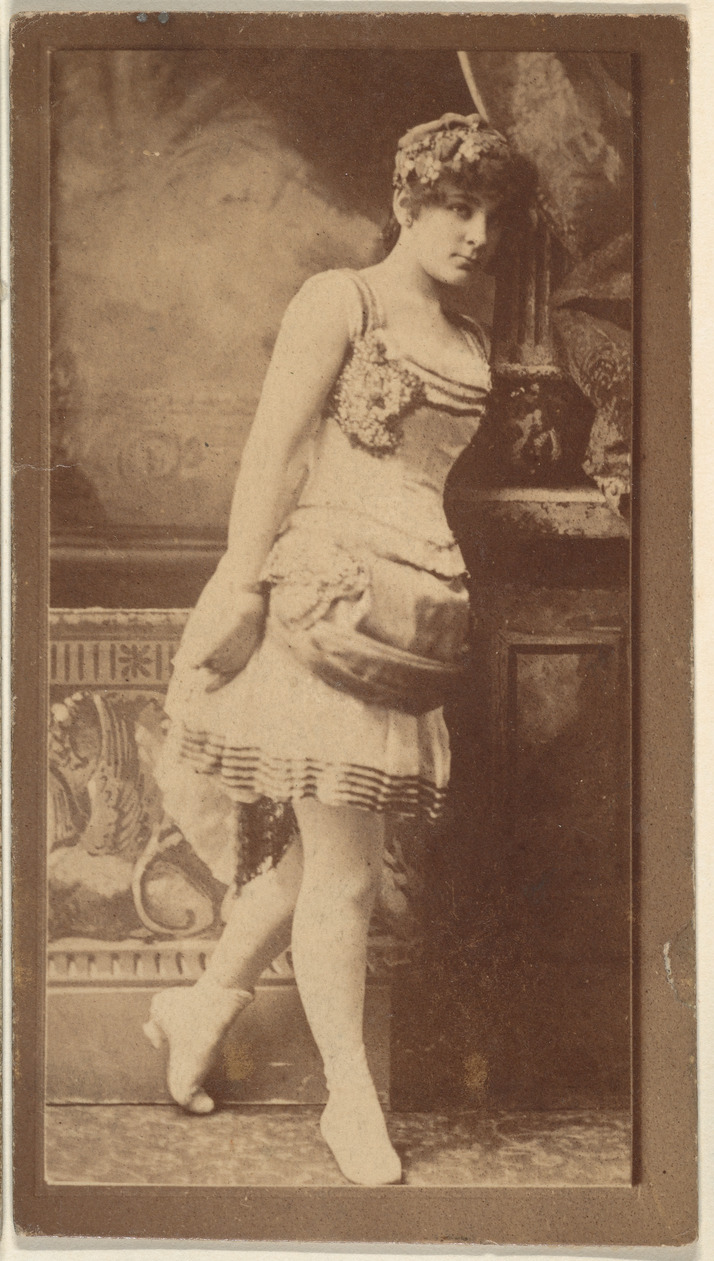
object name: photograph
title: Actress leaning on column, from the Actresses series (N668)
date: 1888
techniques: albumen silver print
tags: portraits,women,actresses